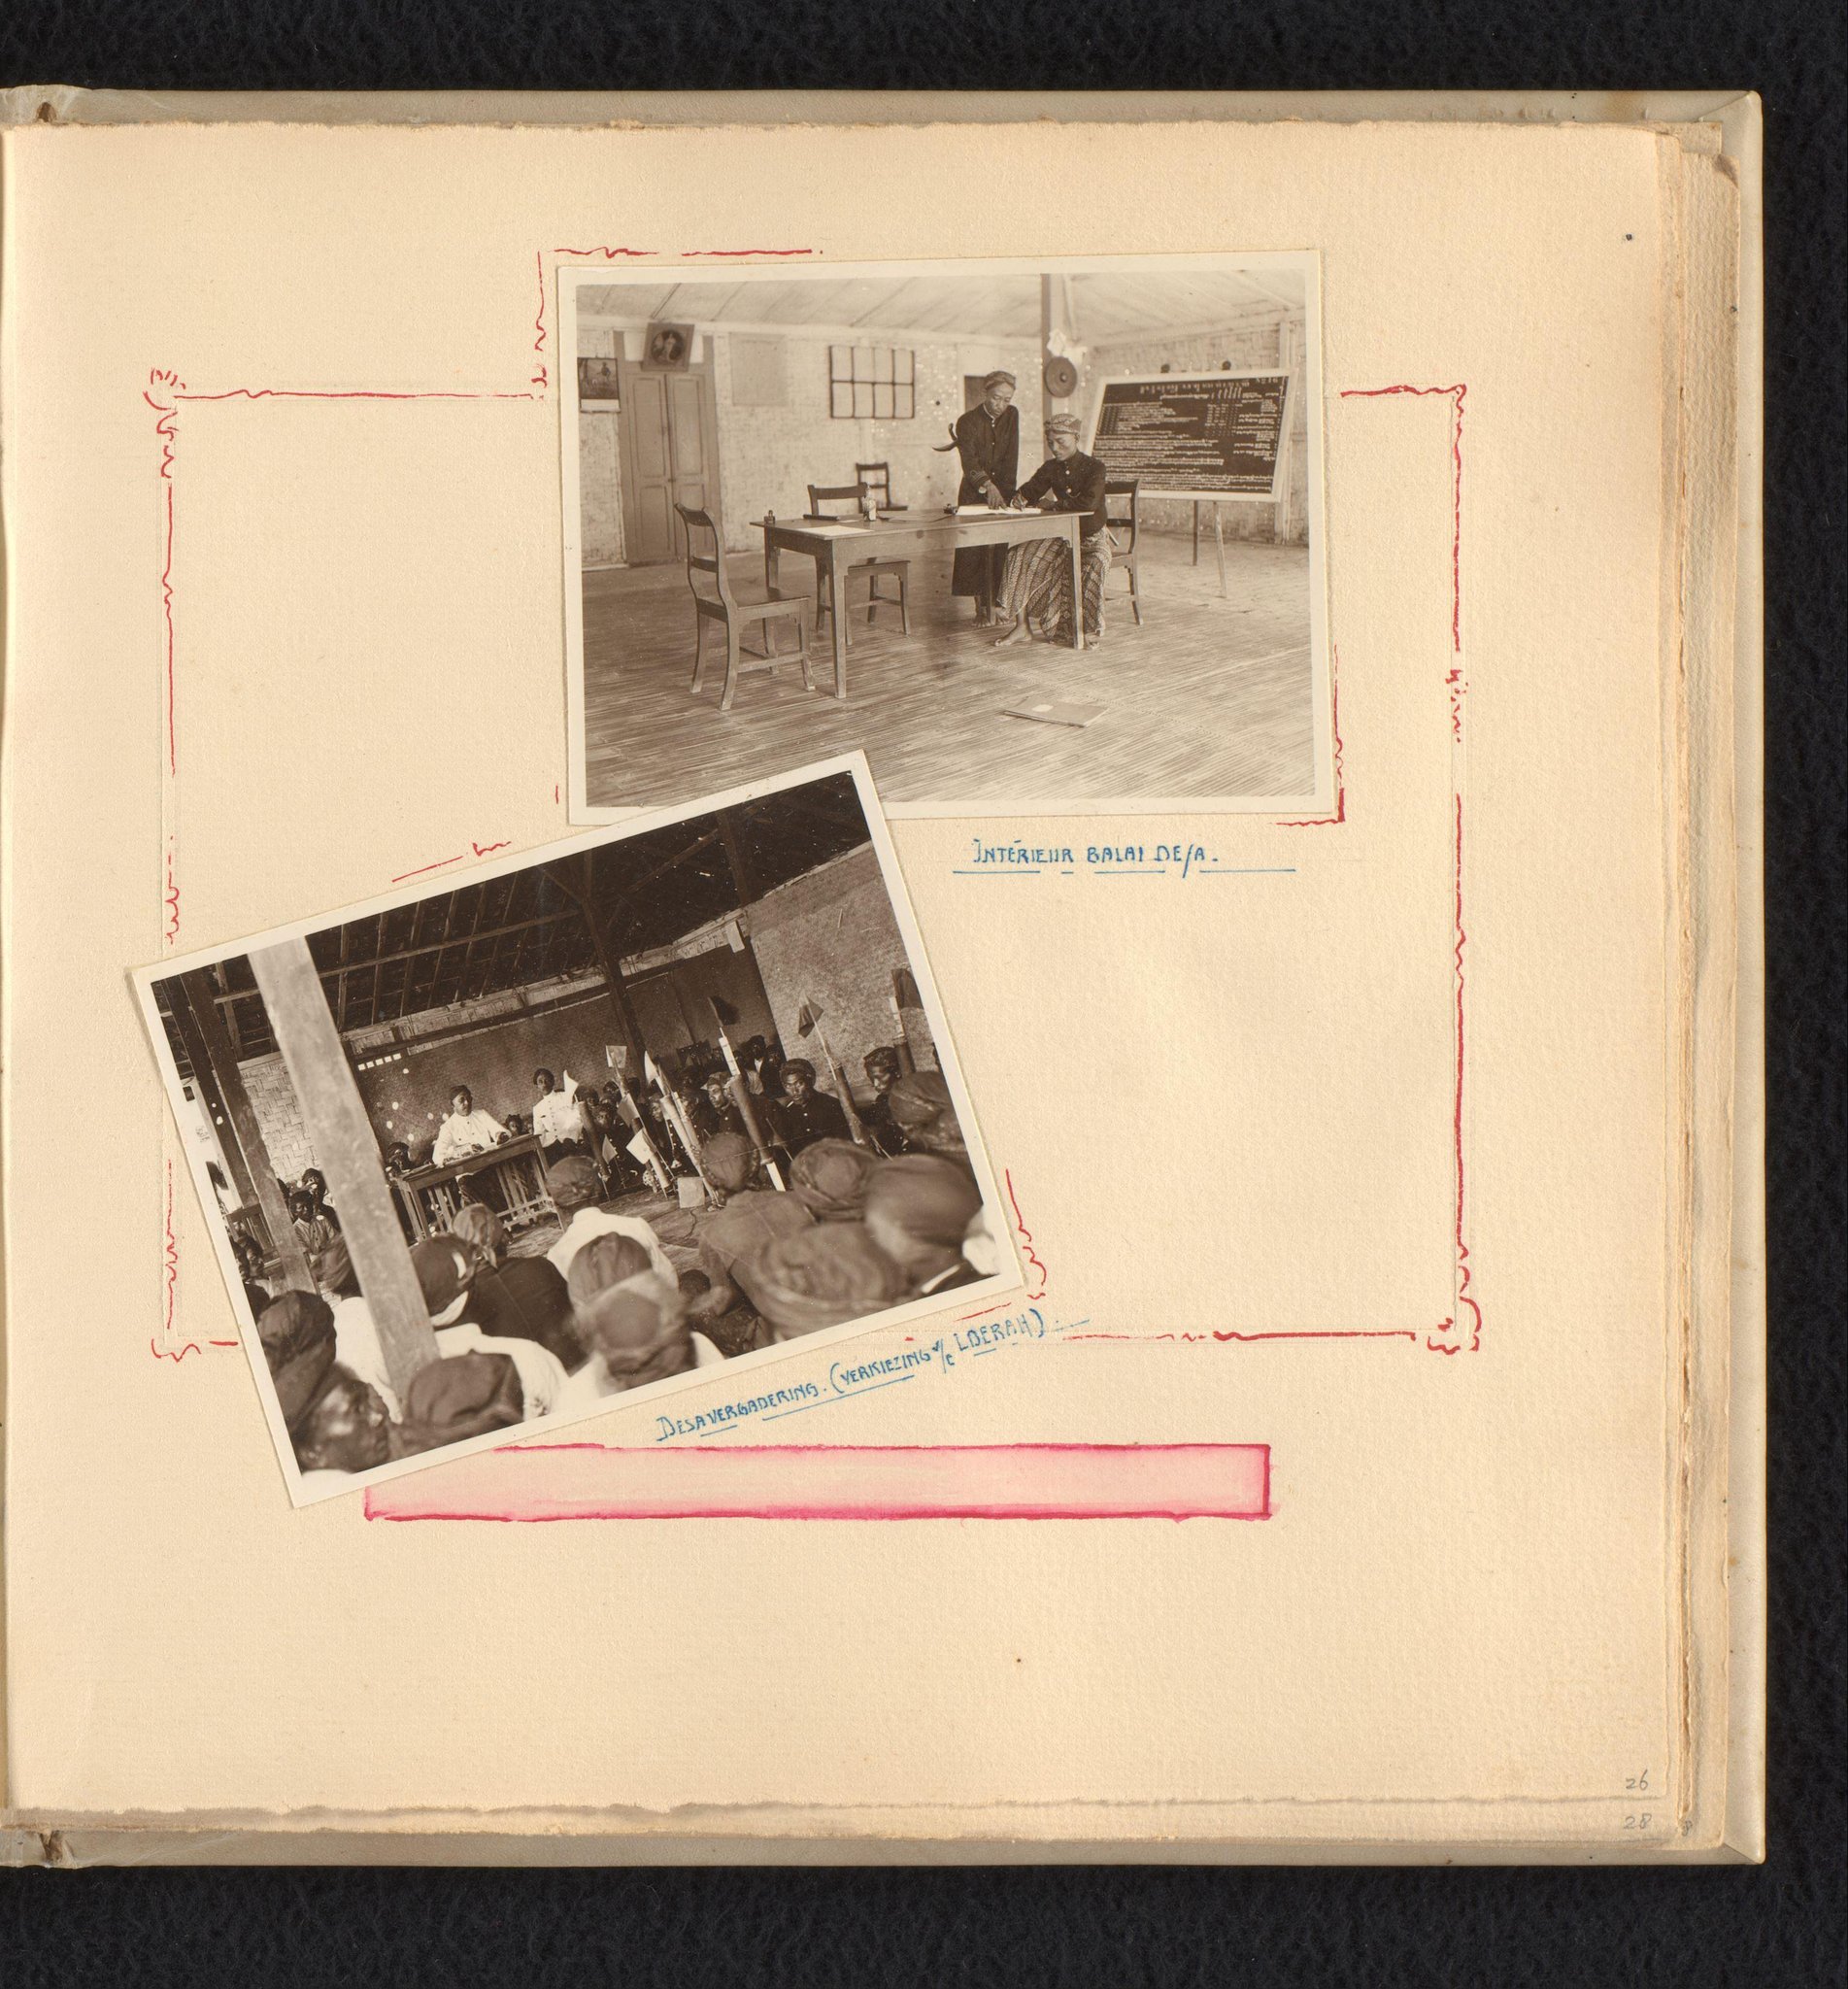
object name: photograph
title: Dorpsbestuur in Grobogan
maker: Anonymous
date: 1910-1928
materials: paper, photographic support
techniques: drawing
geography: grobogan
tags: municipal government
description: Albumblad met twee foto's over het bestuur van een dorp in Grobogan. Het blad is versierd met randwerk om de foto's. Onderdeel van het fotoalbum aangeboden aan J. Habbema door het Binnenlandsch Bestuur Corps van het Regentschap Grobogan, bij het beëindigen van zijn bestuur over het Regentschap, waarschijnlijk in 1928.